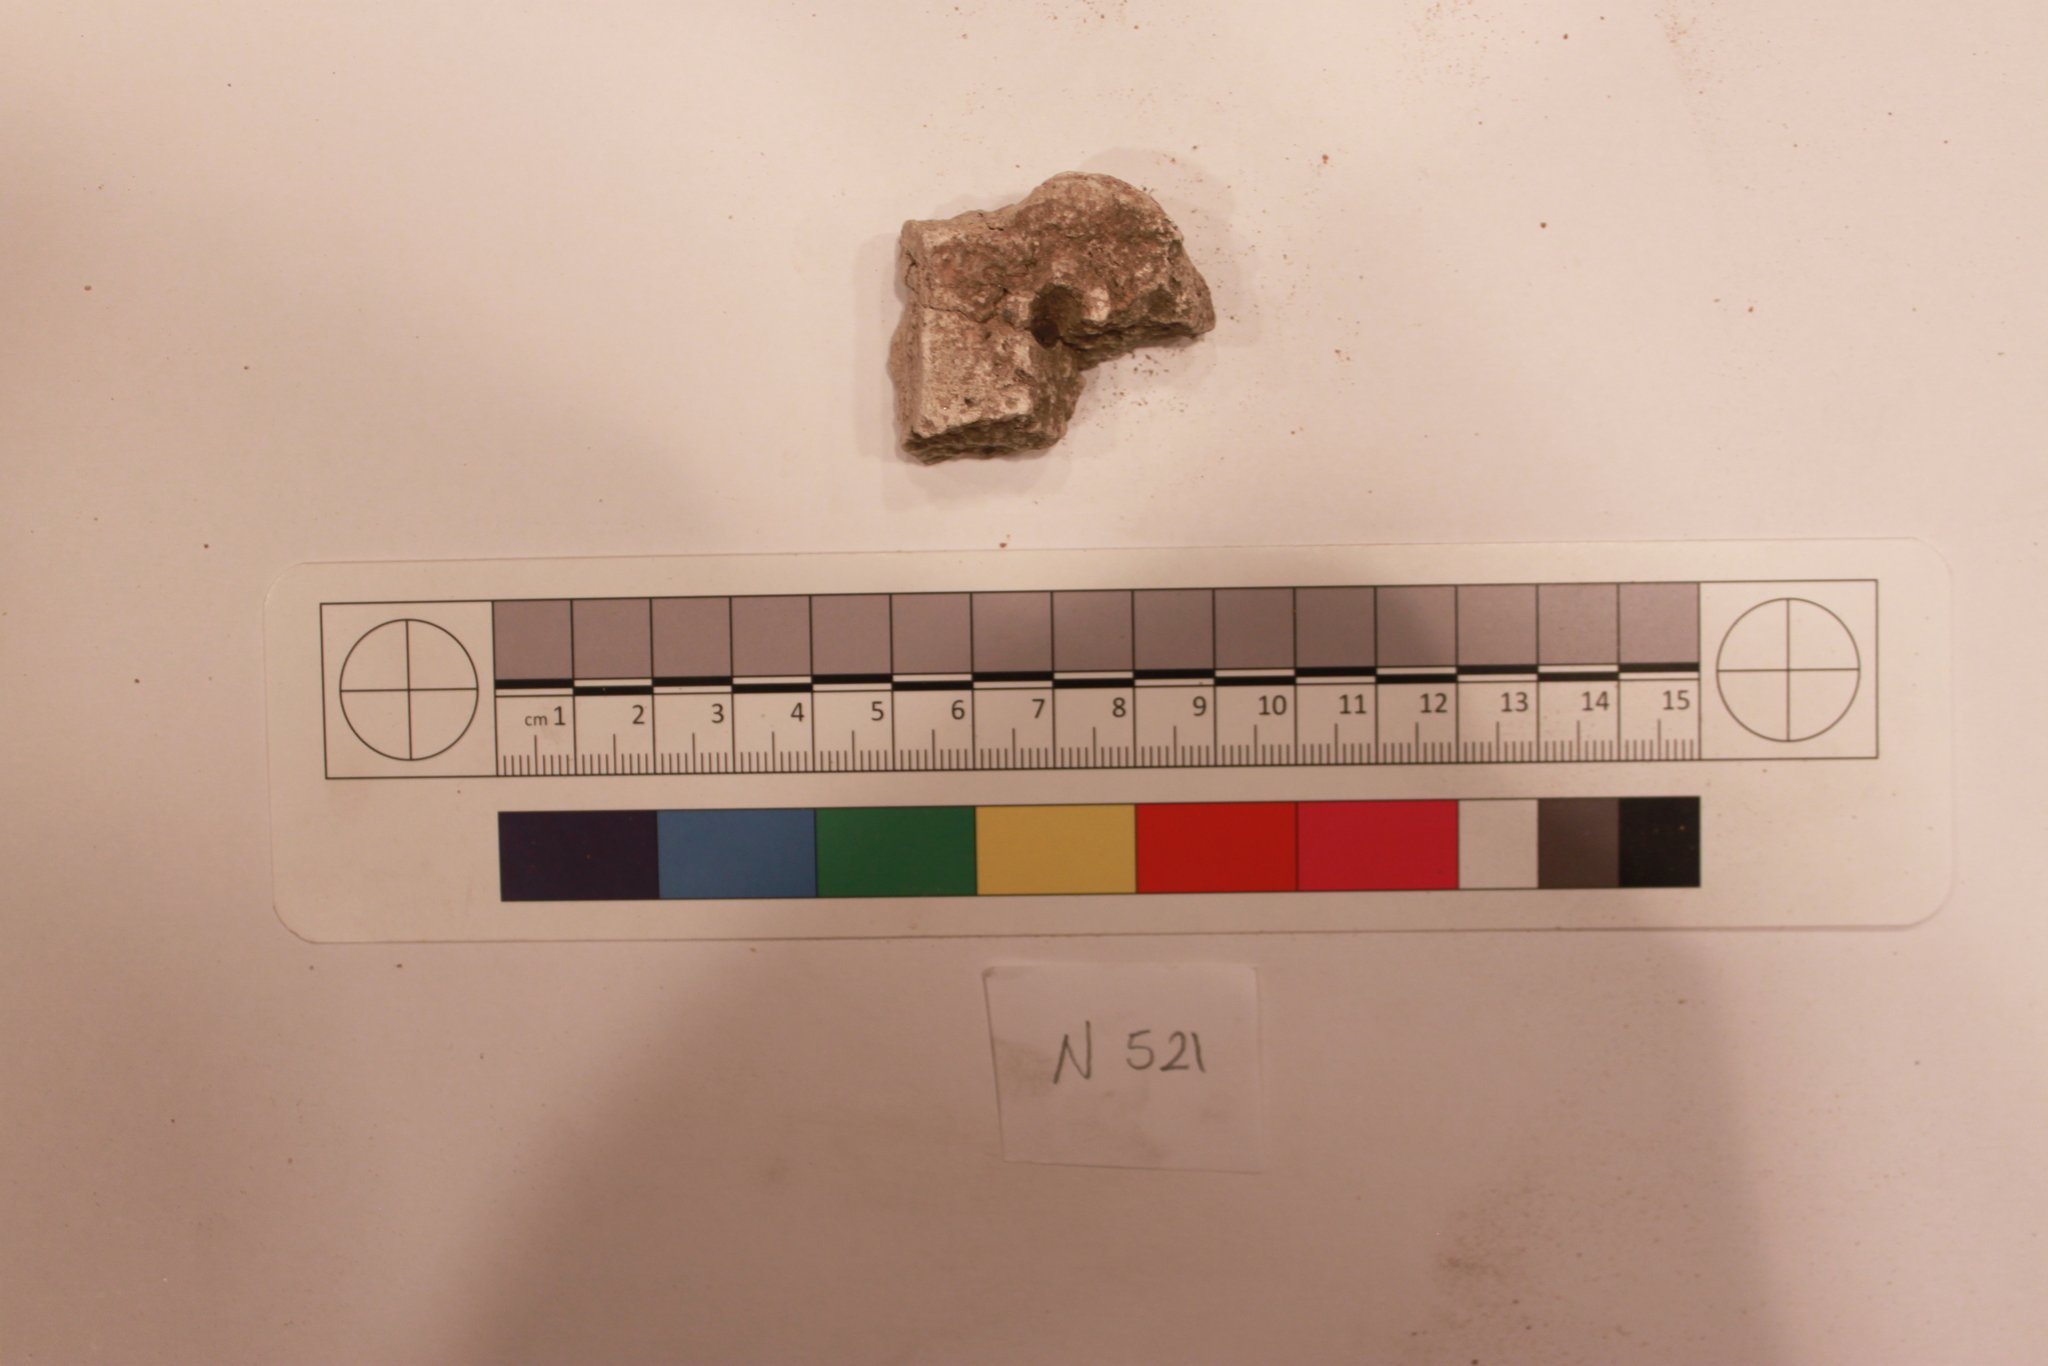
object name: fragment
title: Stucco Fragment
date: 701-1200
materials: plaster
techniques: carving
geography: iran